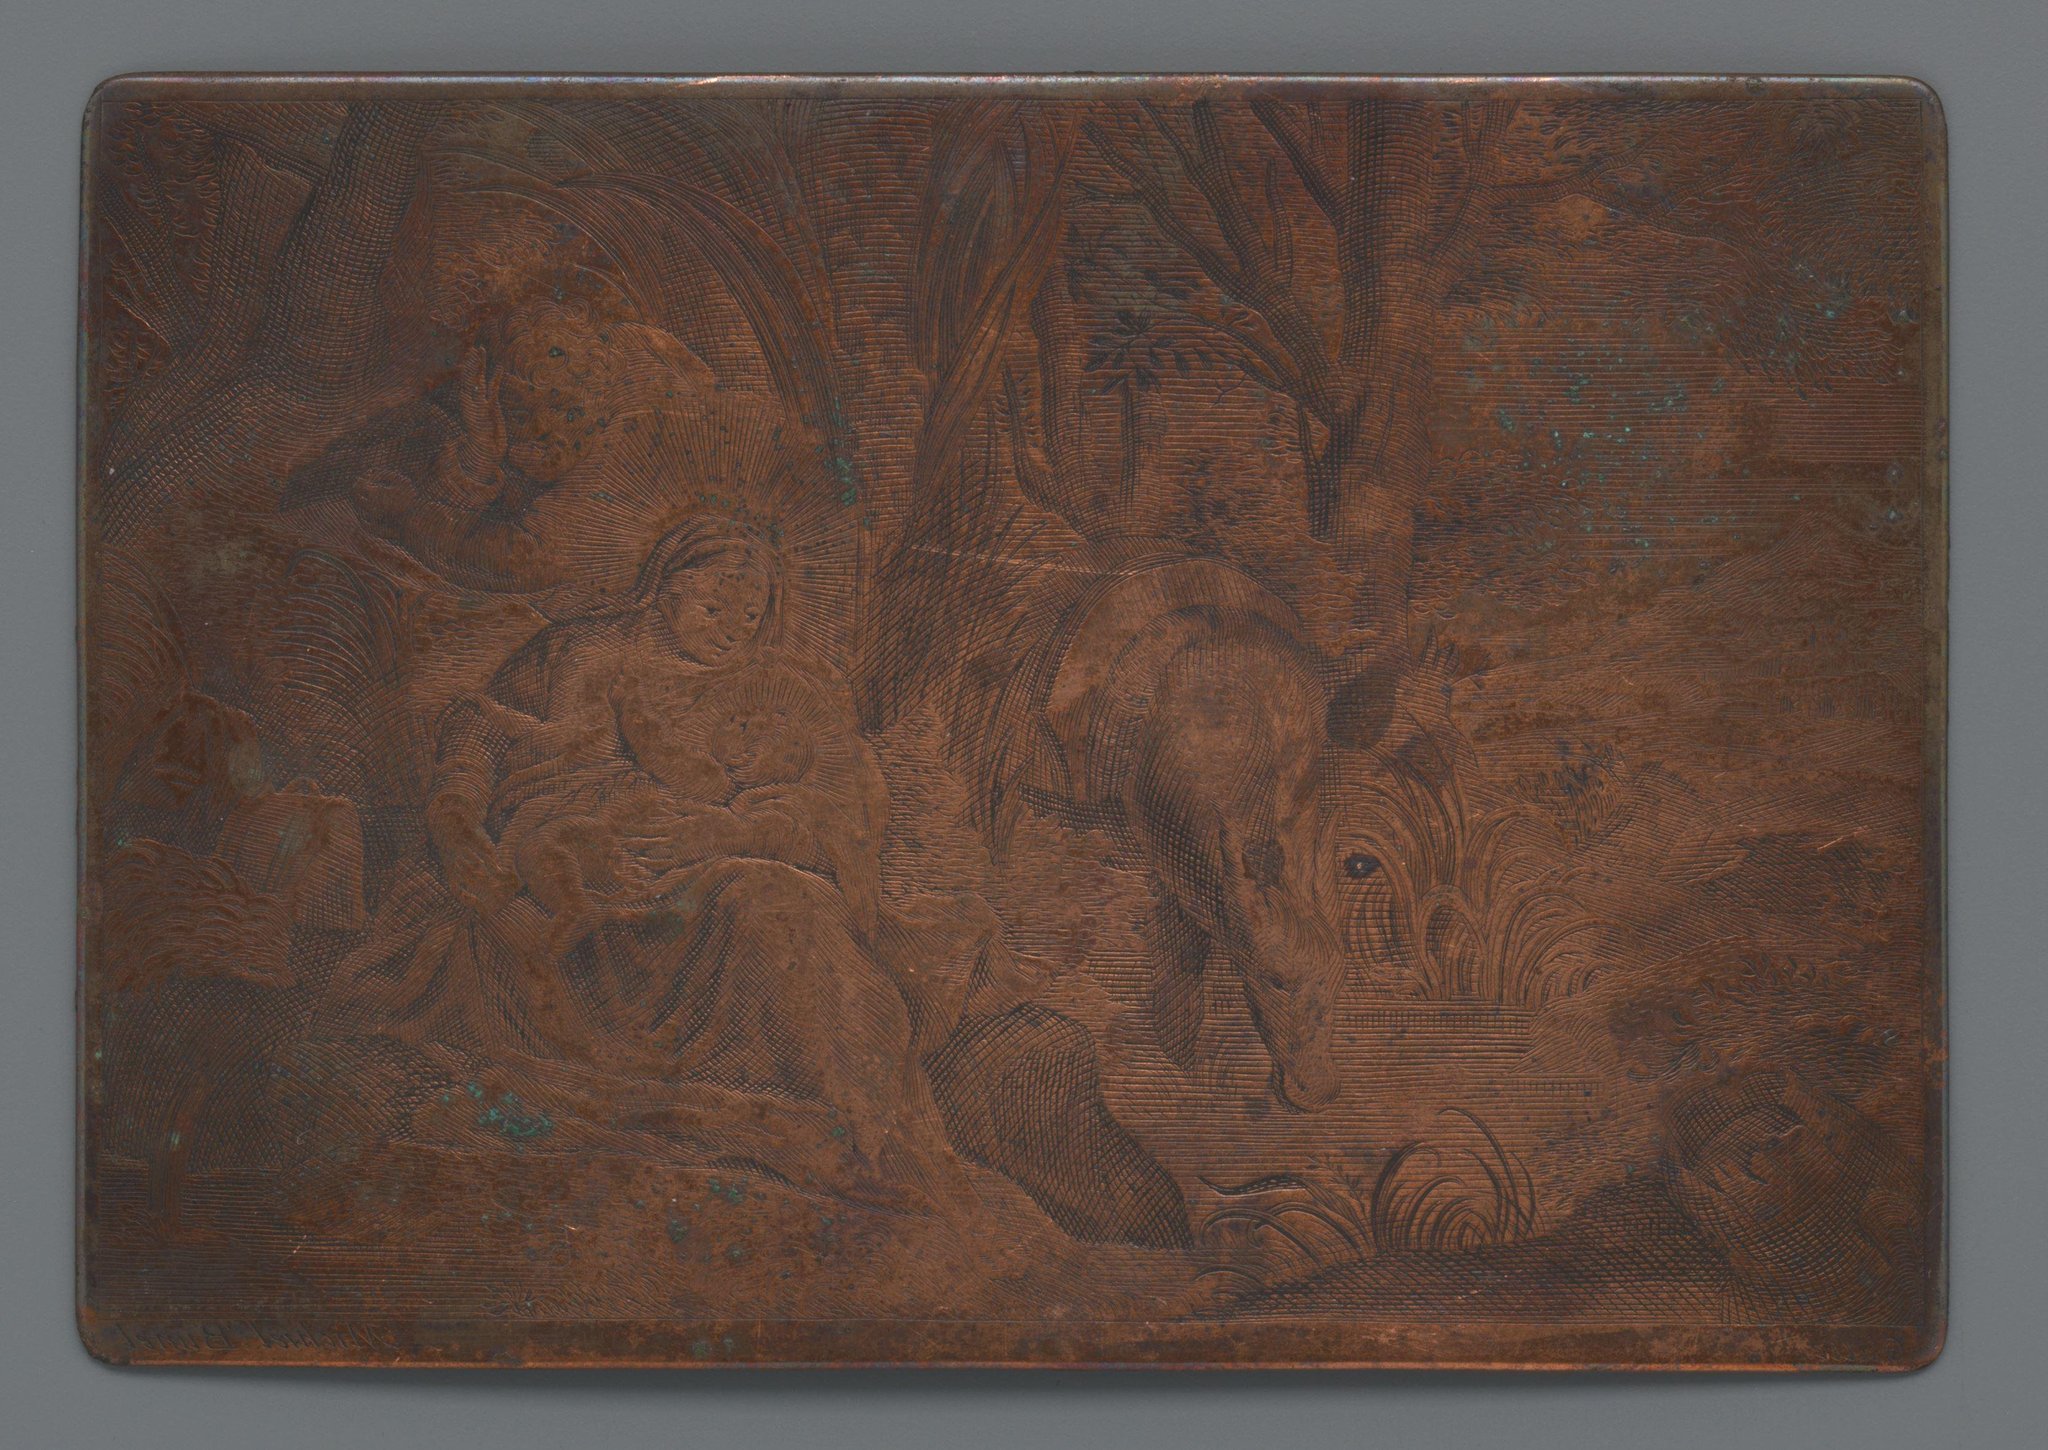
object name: copper plate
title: Koperplaat met de Rust op de vlucht naar Egypte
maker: michel bunel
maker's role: print maker, publisher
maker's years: 1670-1739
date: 1680-1739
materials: copper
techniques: engraving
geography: antwerp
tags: holy family (alone), 'trinitas terrestris', stay of the holy family in egypt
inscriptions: signature: ‘Galle / Michiel Bunel’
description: De platen (RP-D-2014-9-1 t/m 35) zijn vrijwel allemaal vervaardigd door anonieme graveurs werkend voor de Antwerpse uitgevers Cornelis Galle, Frans Huberti (Huybrechts), Theodor van Merlen II en Michel Bunel. Vermoedelijk zijn ze uiteindelijk beland in één fonds, wellicht dat van Michel Bunel (1670-1739) en warden sindsdien bij elkaar bewaard. Afwijkend is de grote prent van Henry Verbruggen met een weergave van de Preekstoel uit de St. Gudule-kerk te Brussel. Twee prenten zijn verpakt in een oude afdruk van de prent, zoals te doen gebruikelijk in uitgeverijen (vergl. oude platen in Museum Plantijn Moretus, Antwerpen). Van 8 platen heeft de vorige eigenaar afdrukken laten maken op modern papier.